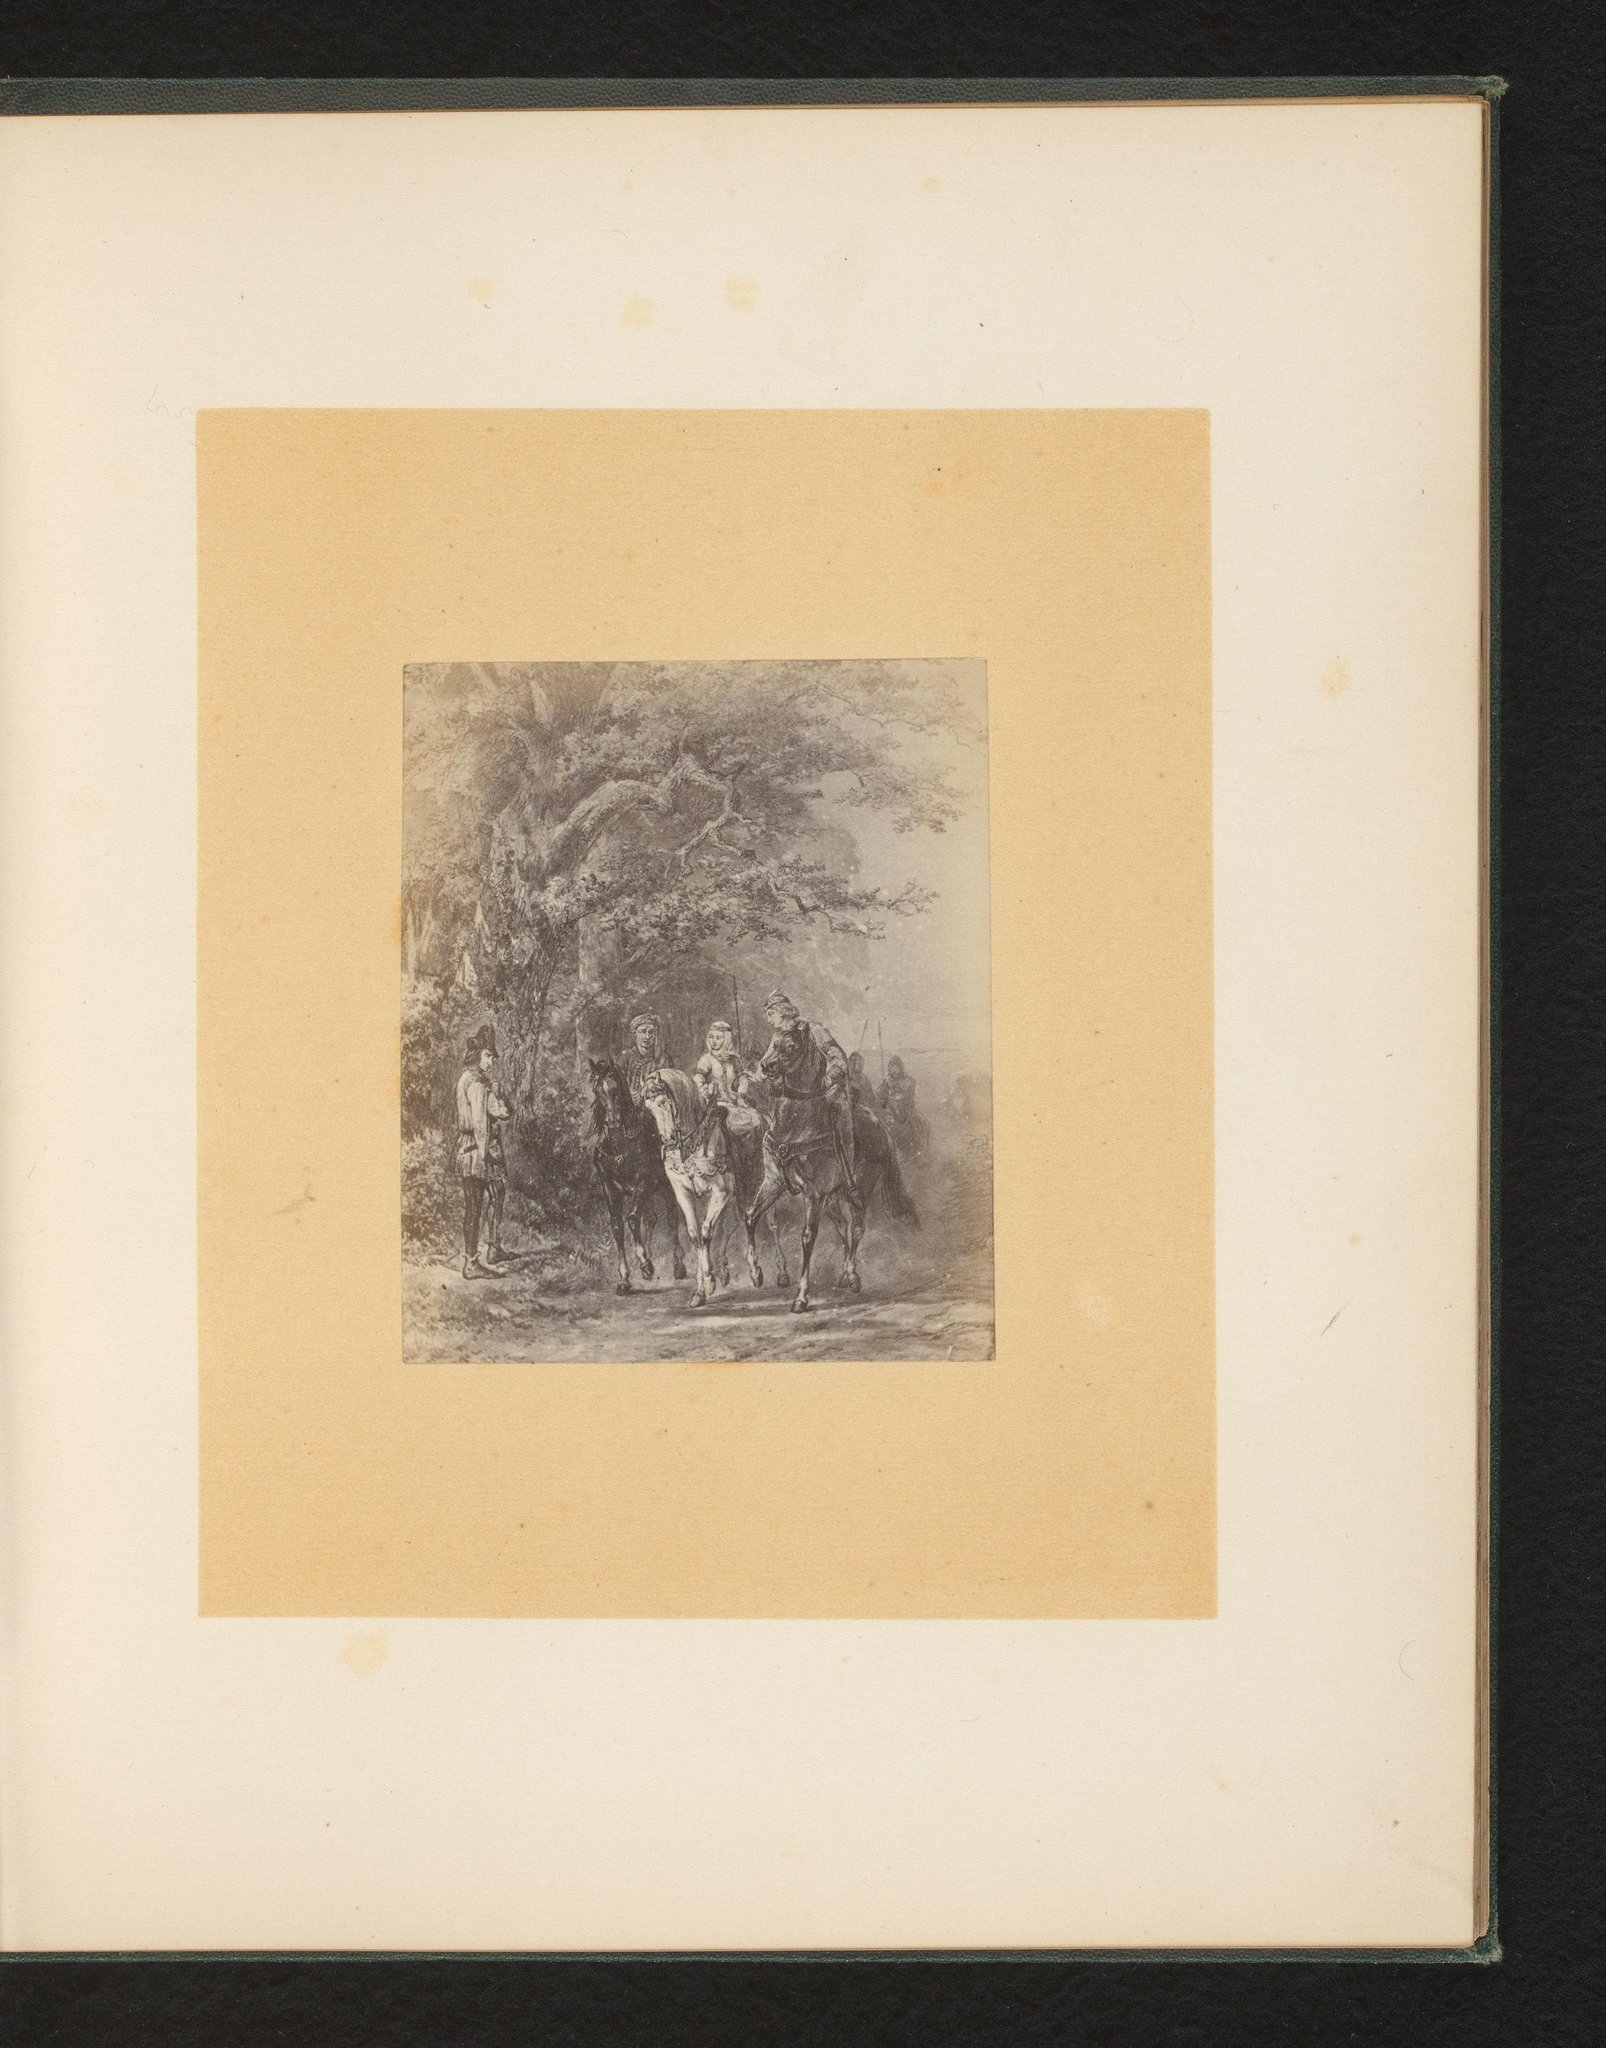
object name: page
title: Fotoreproductie van een schilderij van ter illustratie van Van Lenneps De Roos van Dekama door Cornelis Springer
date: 1870-1880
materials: paper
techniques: albumen print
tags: picture, painting